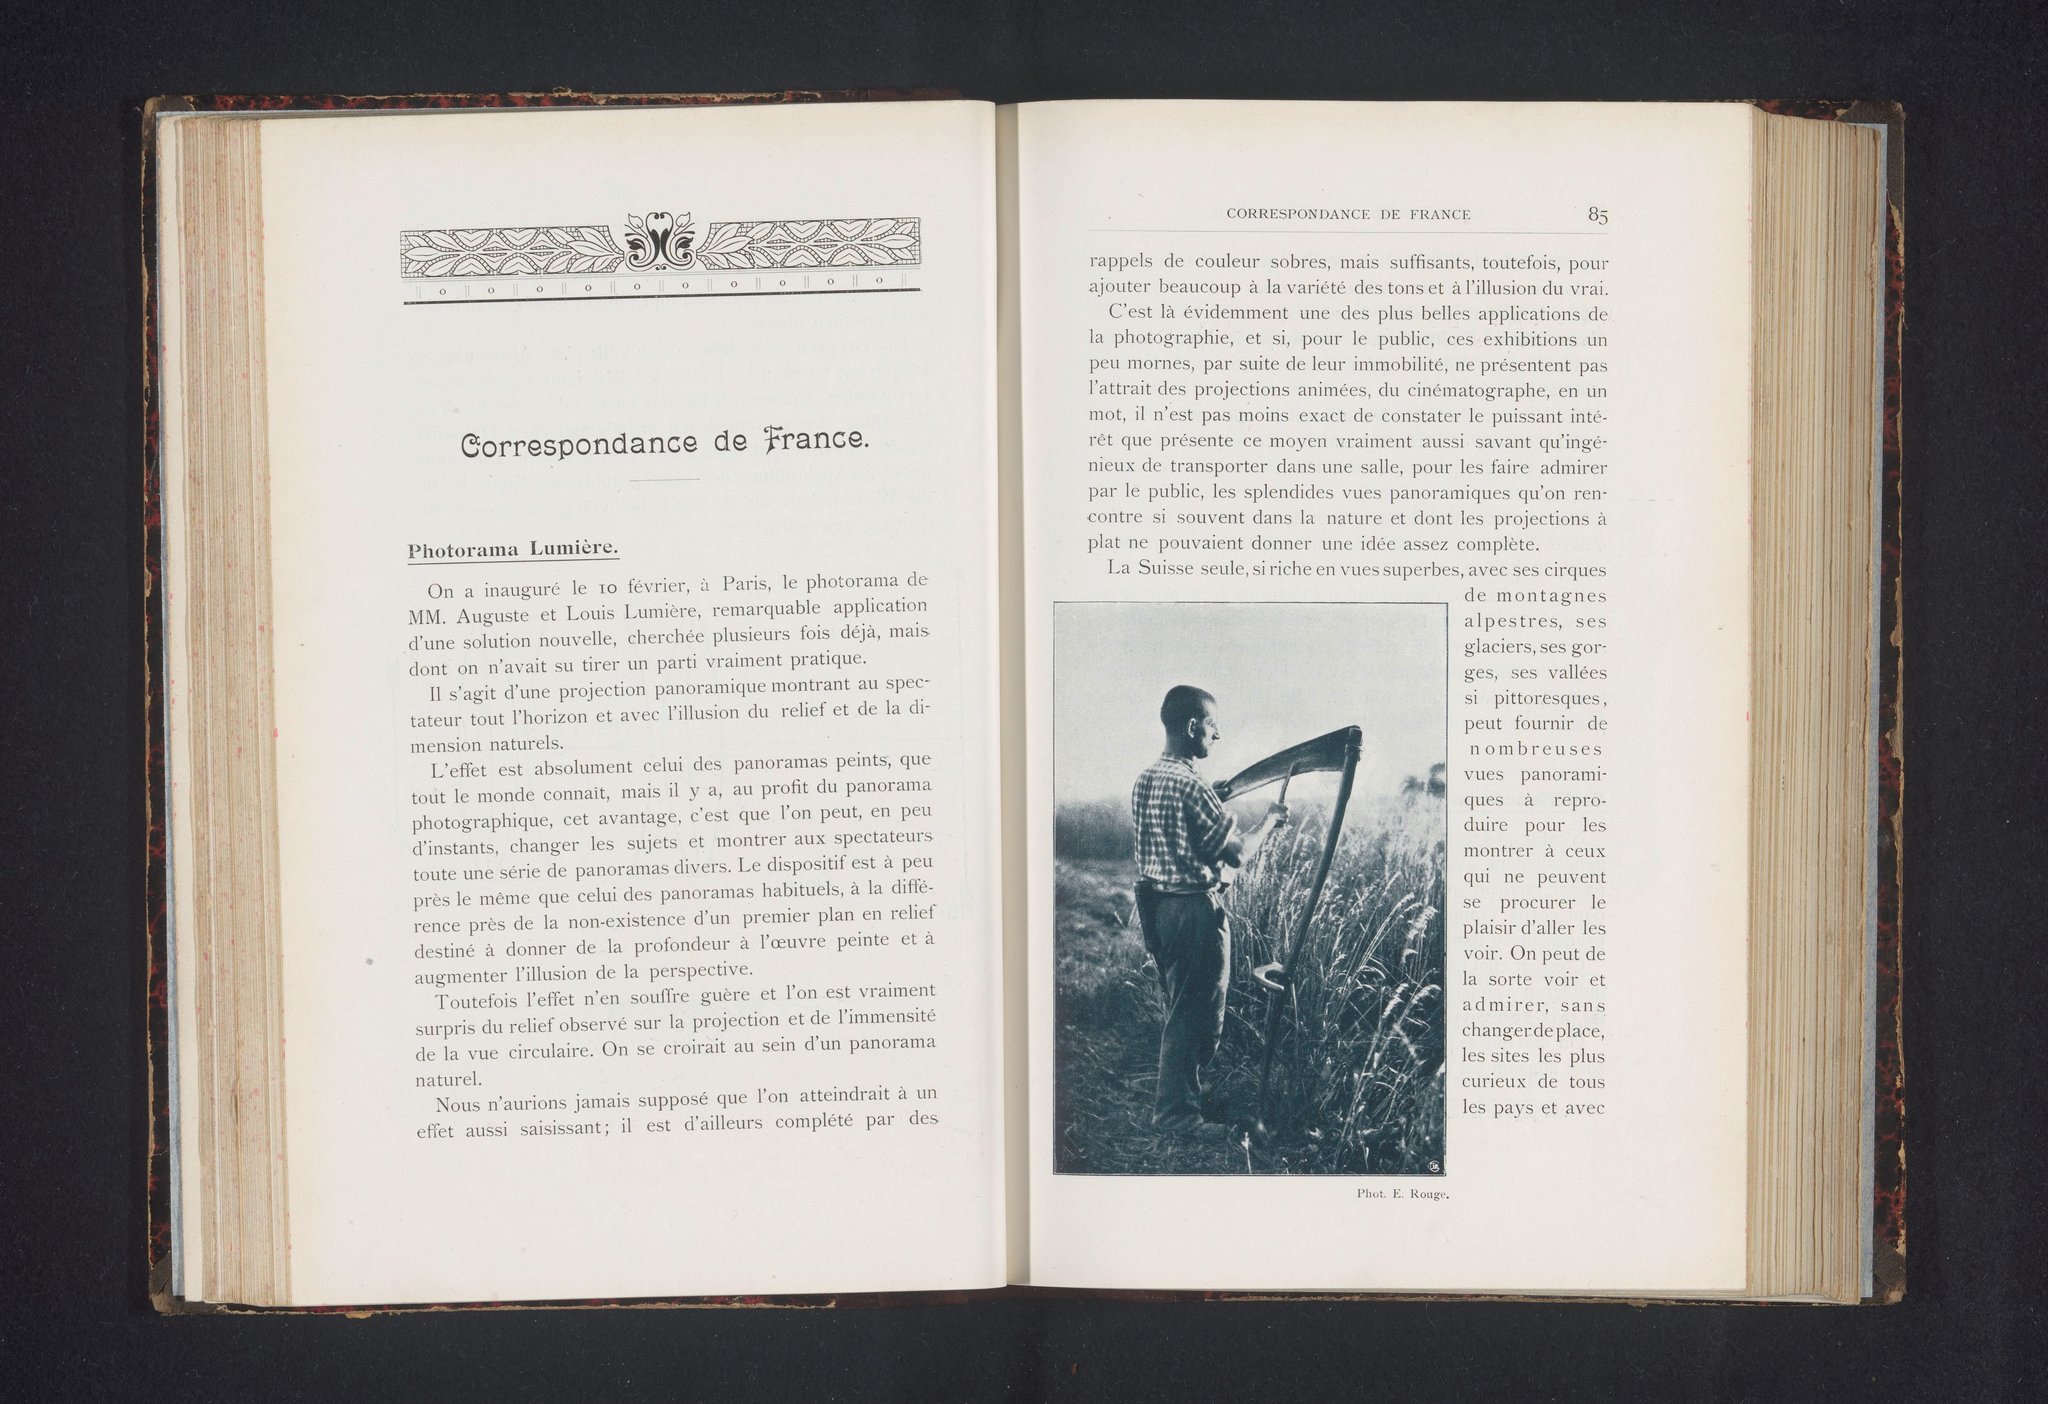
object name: page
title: Man met een zeis op het land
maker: e. rouge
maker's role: fotograaf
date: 1897-1902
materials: paper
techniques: autotype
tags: agricultural implements: scythe, historical persons, agriculture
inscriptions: monogram: ‘C. Cie’